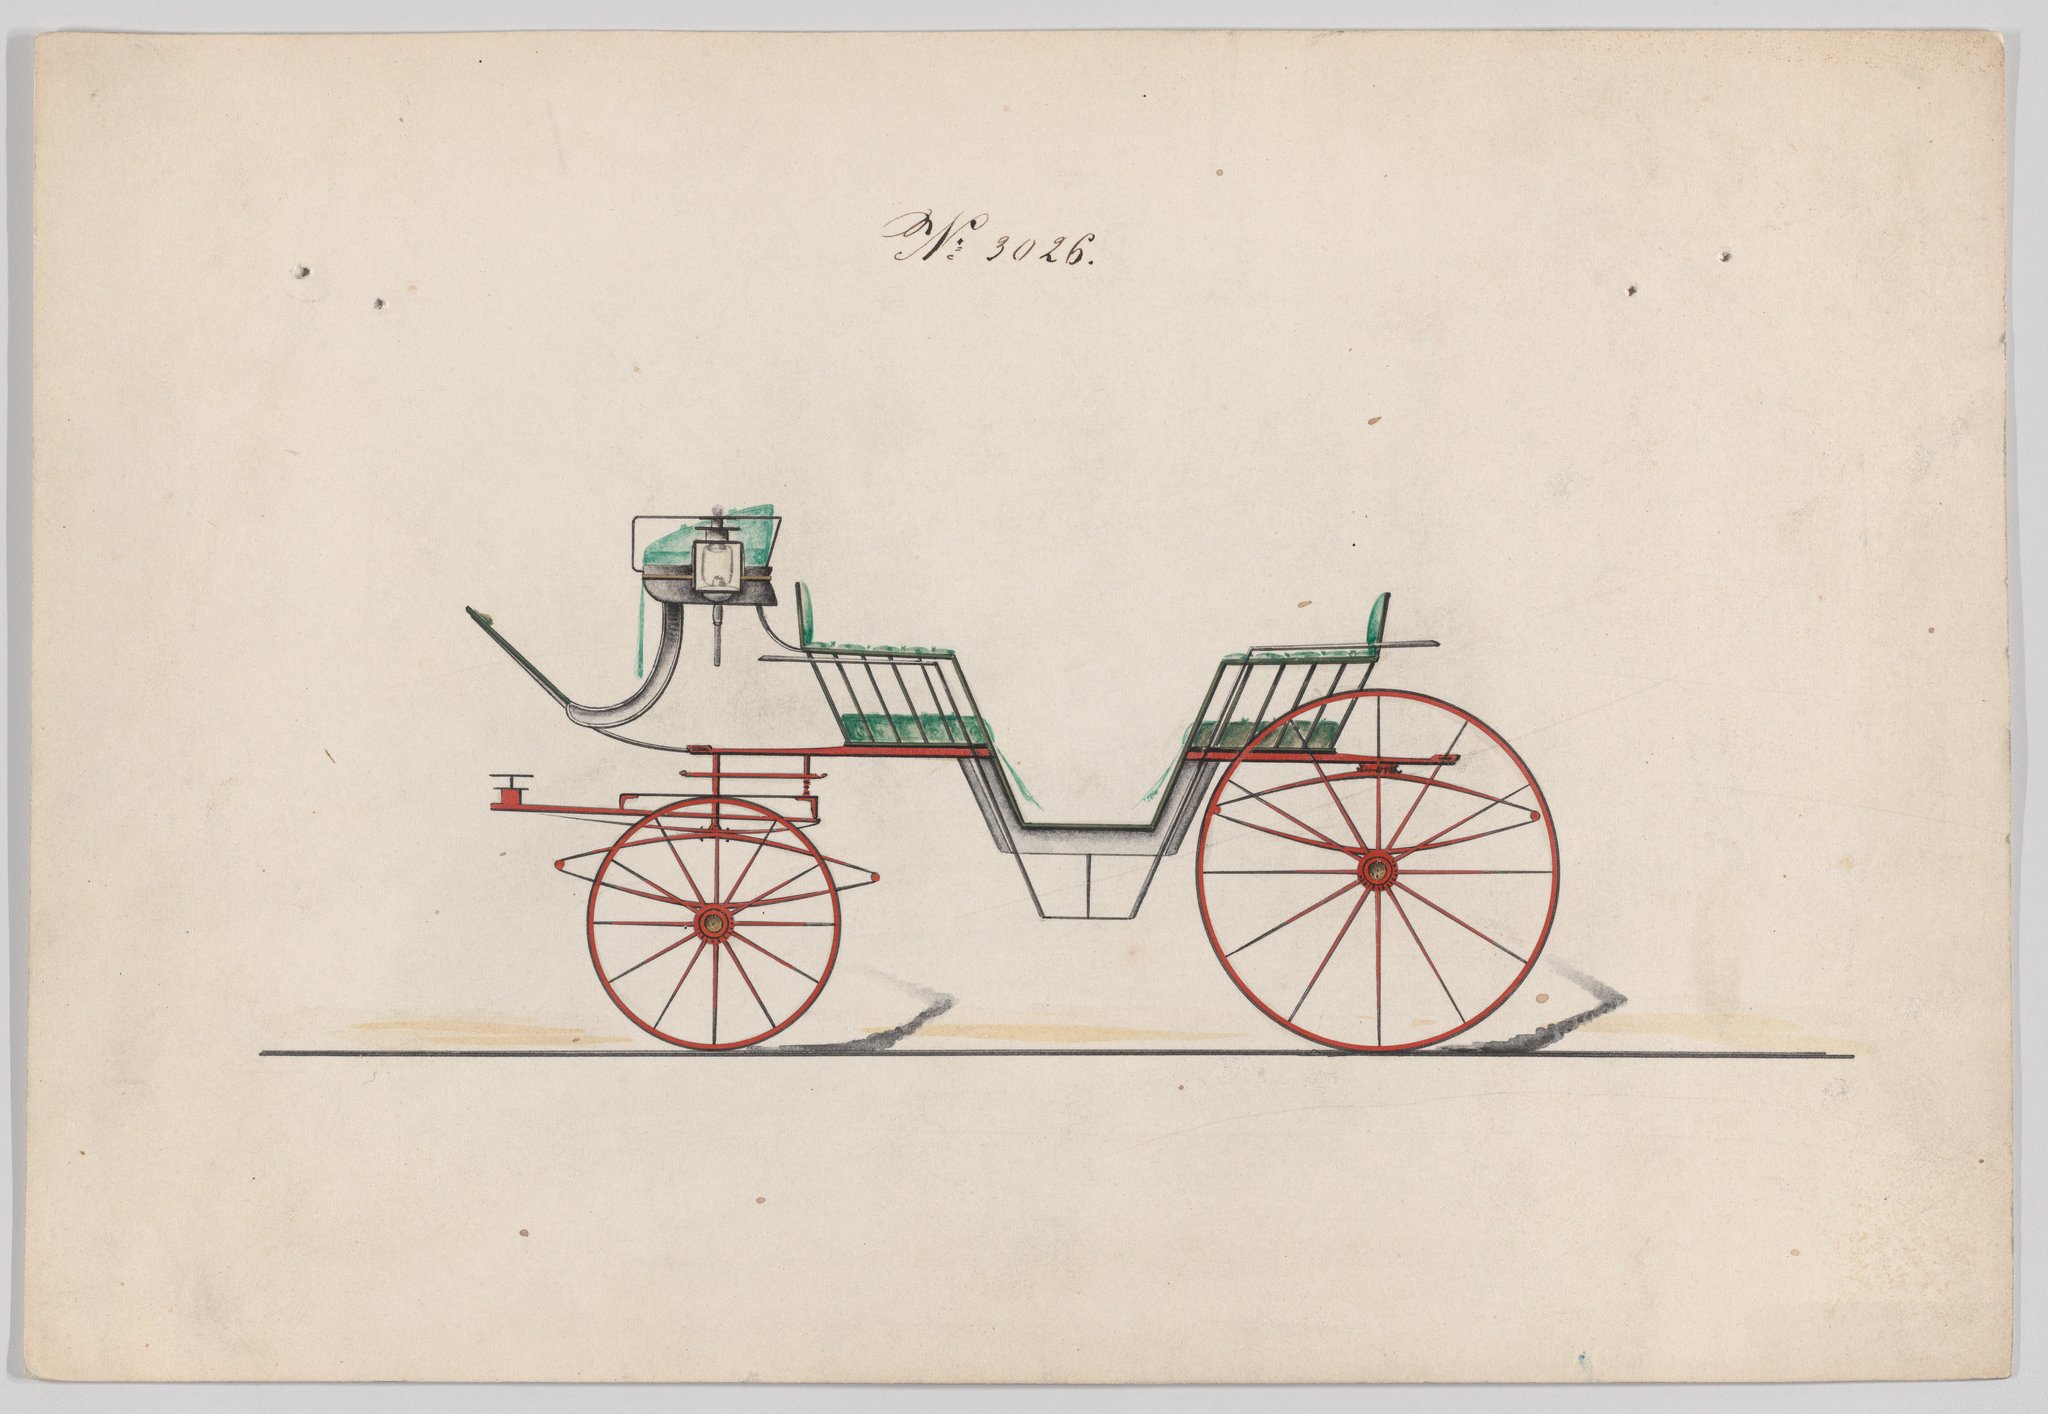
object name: drawing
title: Vis-a-Vis #3026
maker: brewster & co.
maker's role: manufacturer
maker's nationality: american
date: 1874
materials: gouache, gum arabic, ink, watercolor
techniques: pen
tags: carriages